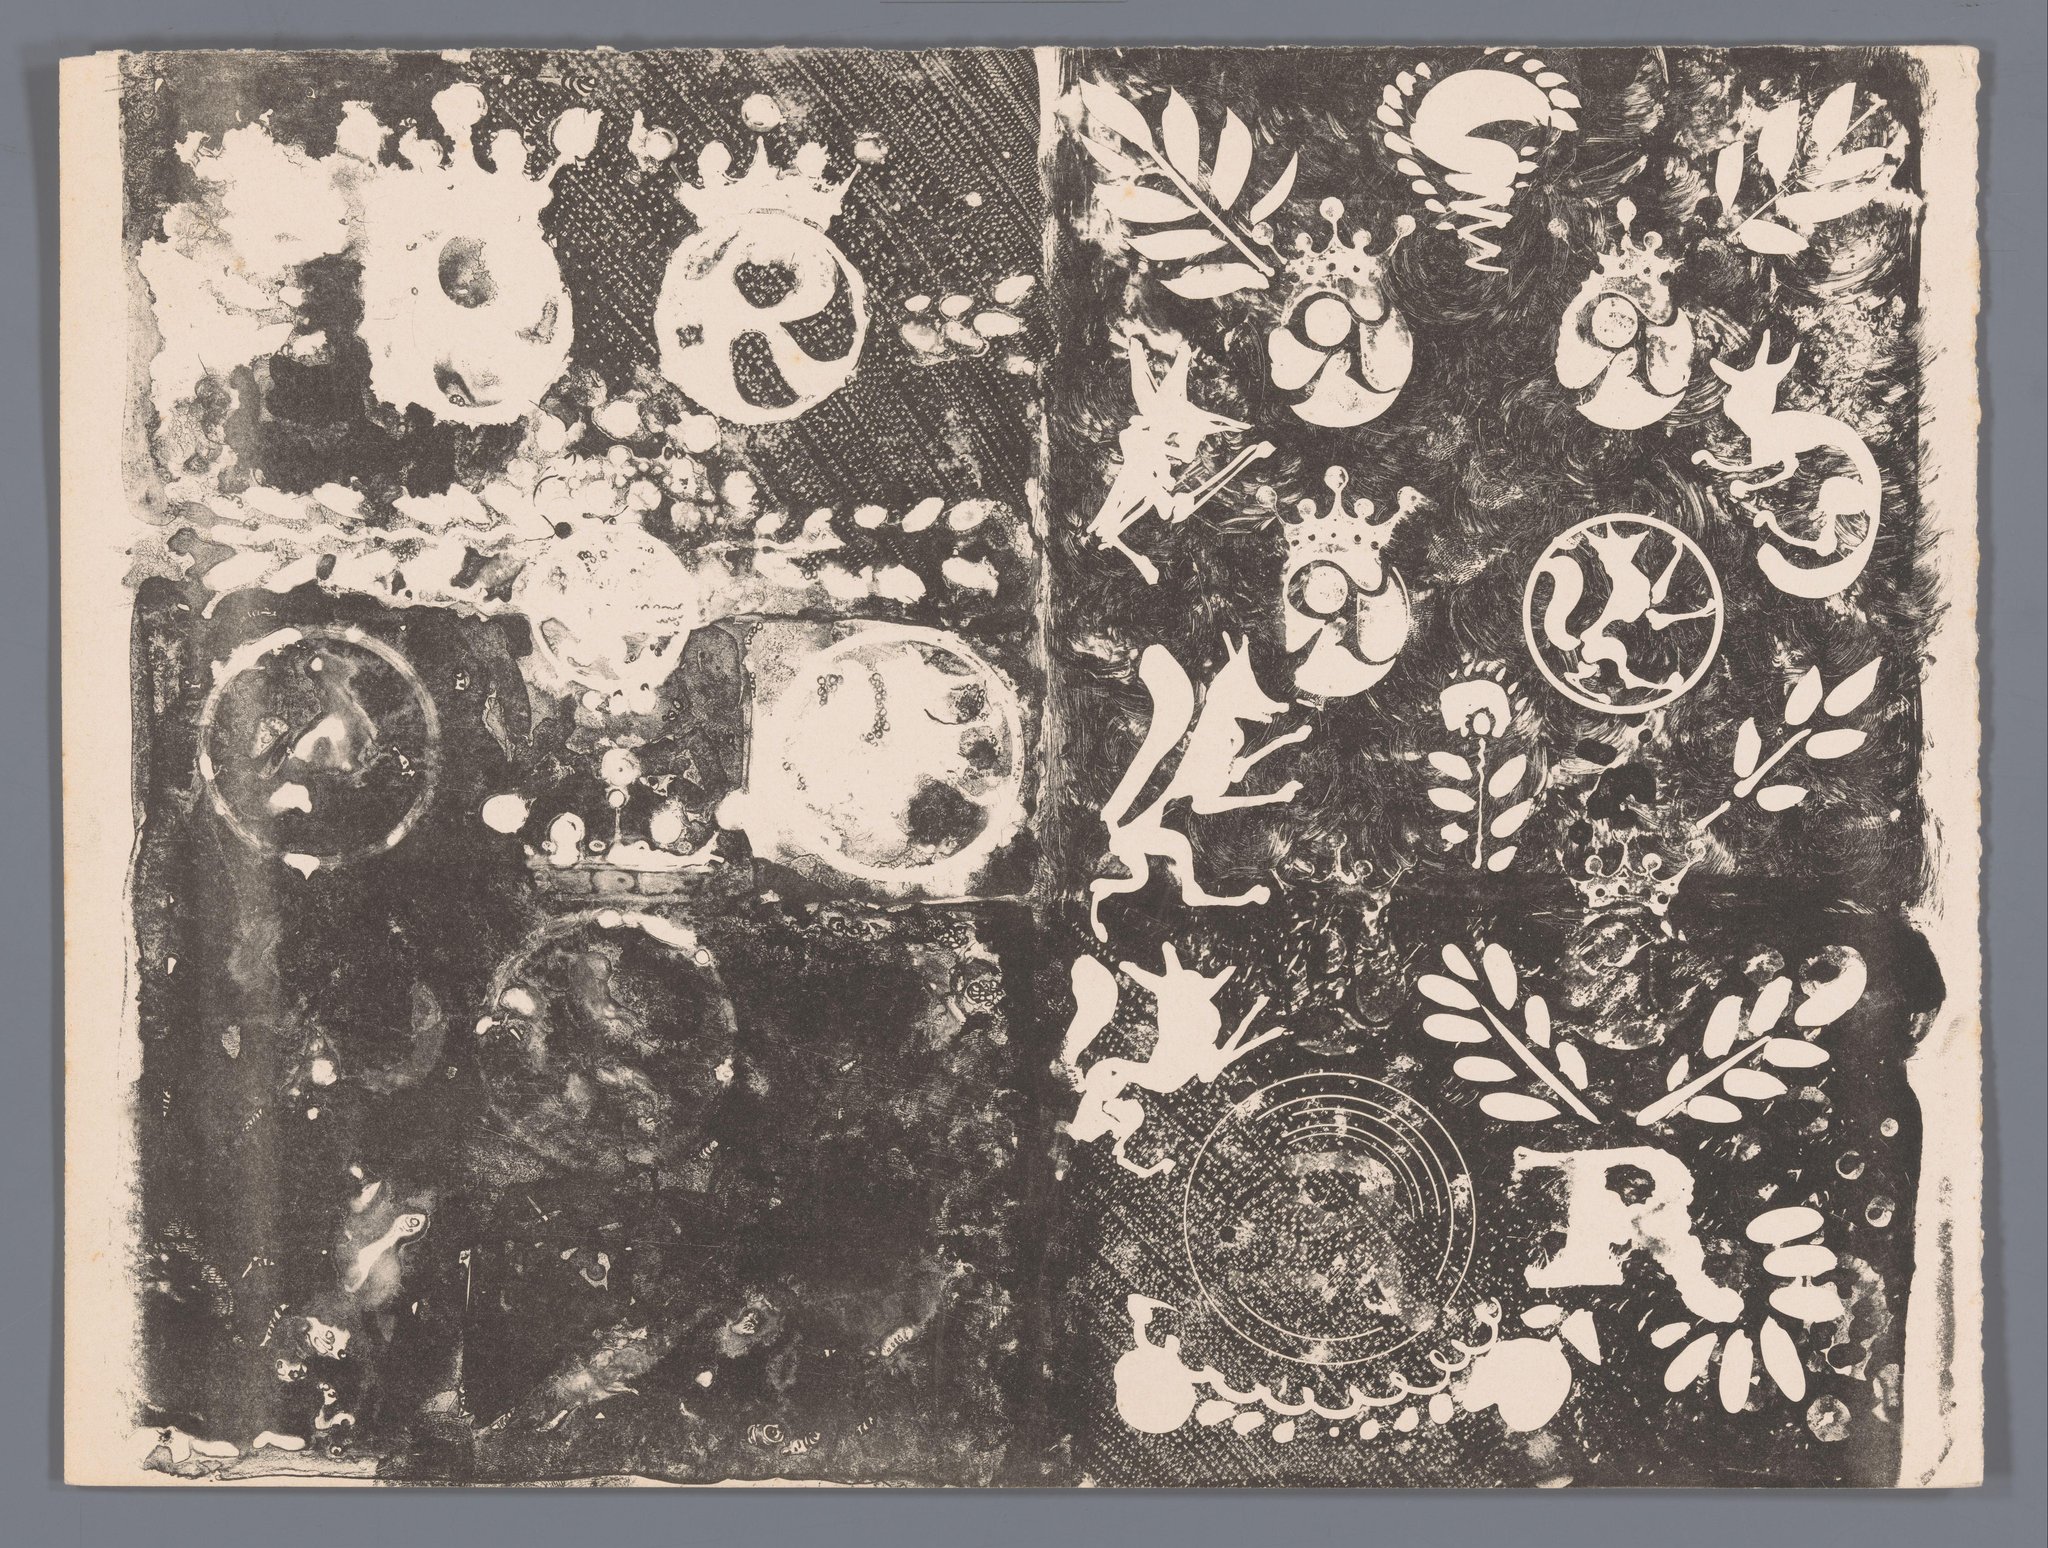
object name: endleaf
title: Verschillende uitprobeersels voor ontwerpen voor Reinaert de Vos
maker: bernard willem wierink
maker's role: draughtsman, print maker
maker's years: 1856-1939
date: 1910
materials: paper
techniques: lithograph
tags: fable of reynard the fox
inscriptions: collector's mark: Lugt 2228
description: Blad met uitprobeersels voor ontwerpen voor: Streuvels, Stijn (Frank Lateur). Reinaert de Vos naar verschillende uitgaven van het middeleeuwsche epos. Amsterdam: L.J. Veen, 1910.